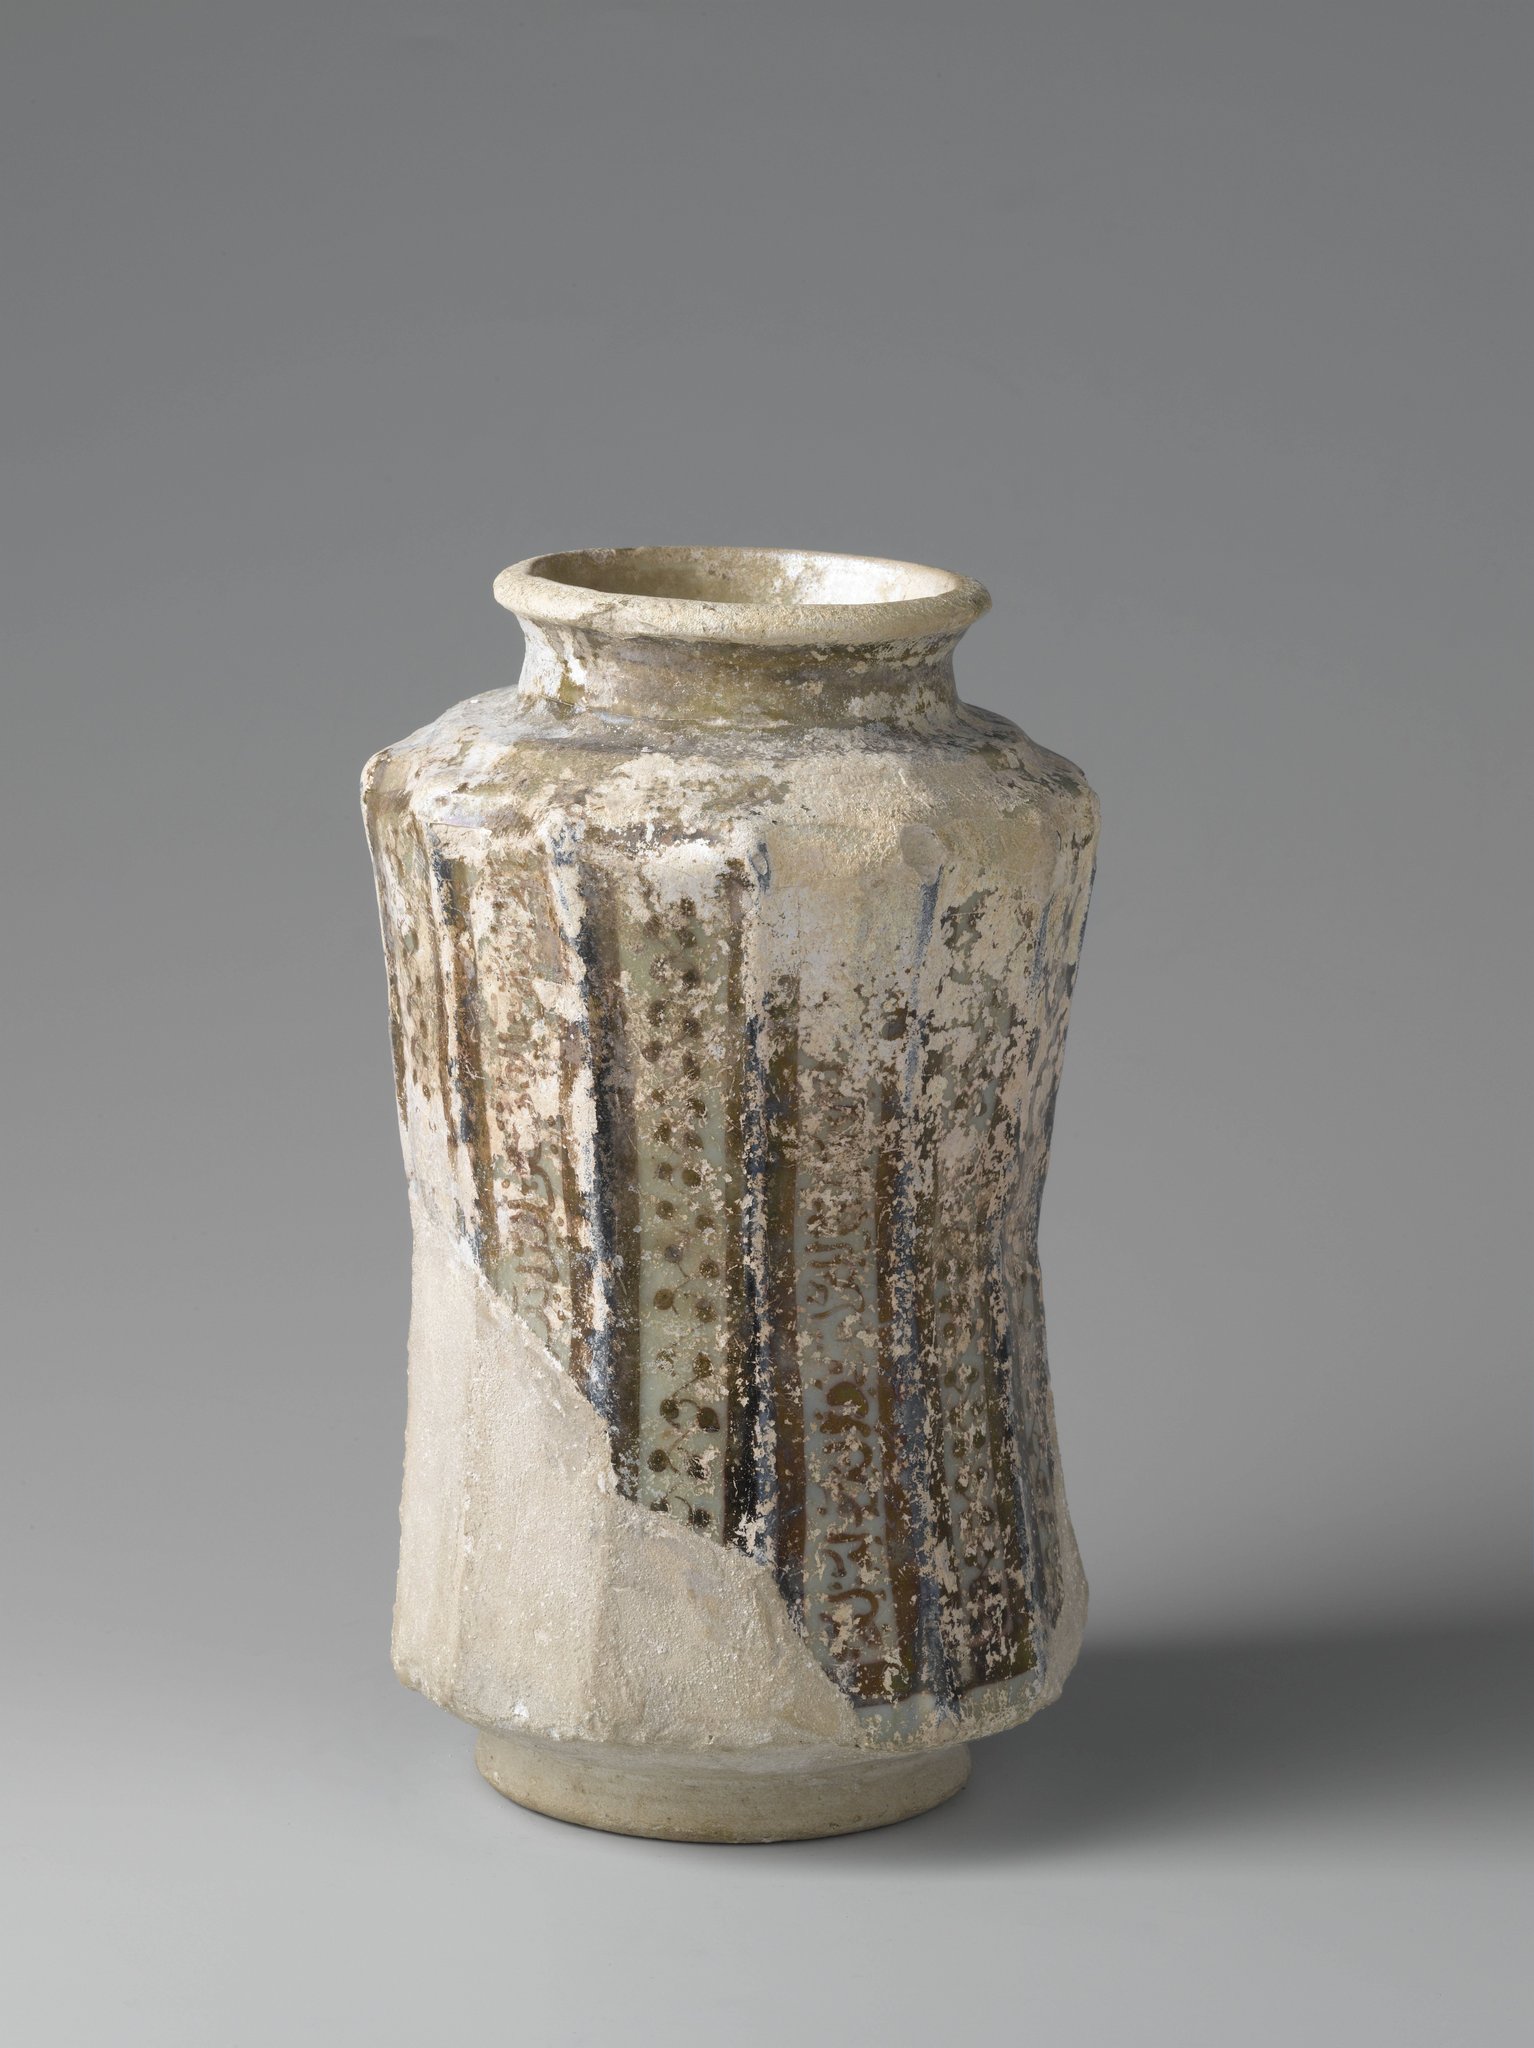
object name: apothecary jar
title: Medicinal jar with vertical ornamental borders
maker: Anonymous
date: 1200-1299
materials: earthenware, glaze, luster, paint, quartz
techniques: firing, turning, vitrification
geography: syria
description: Apothekerspot van kwarts-fritgoed gedecoreerd met schrift en ranken in roodbruin luster en blauw in verticale banden op witte ondergrond van glazuur.